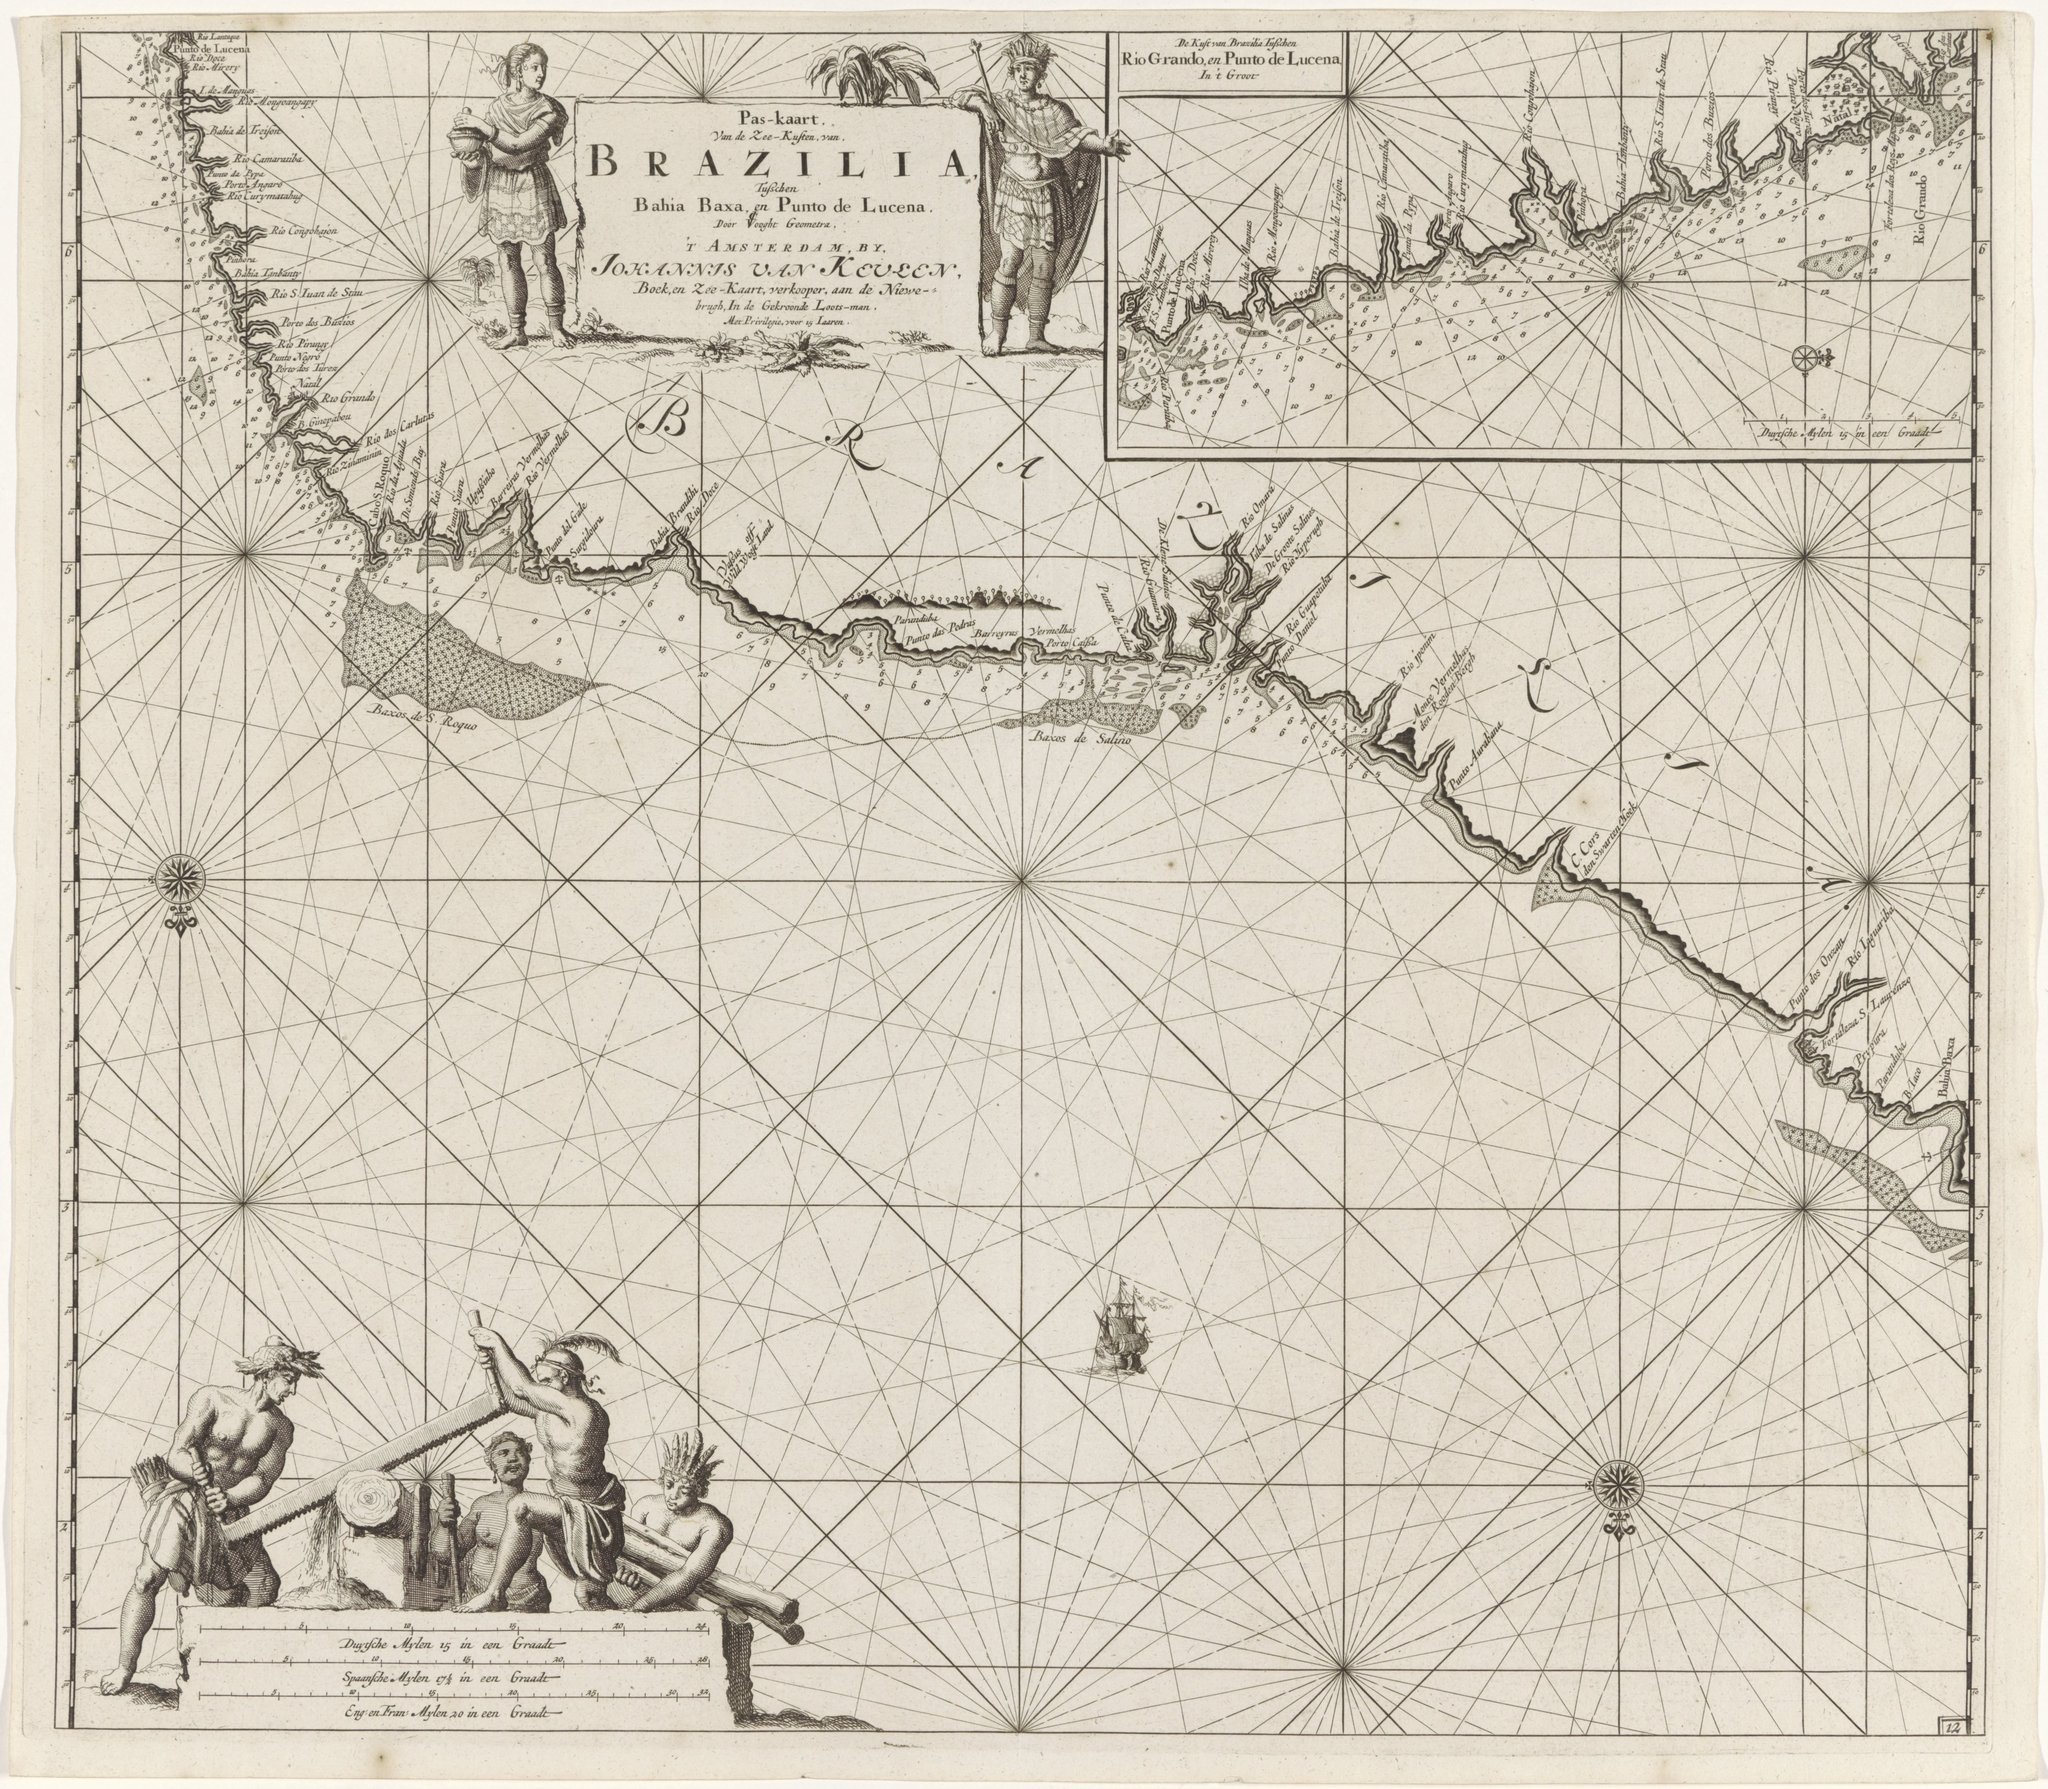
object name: print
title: Paskaart van een gedeelte van de noordoostkust van Brazilië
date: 1683-1799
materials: paper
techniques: engraving, etching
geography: amsterdam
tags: sailing-ship, sailing-boat, woodcutting, woodcutter ~ forestry, indigenous peoples of south america, trees: palm-tree, americans with african roots, african-americans, brasil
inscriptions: collector's mark: Lugt 2228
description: Paskaart van een gedeelte van de noordoostkust van Brazilië en een inzetkaart van de omgeving van de stad Natal, met drie kompasrozen. Middenboven de titel en het adres van de uitgever, geflankeerd door een man met een verentooi en een staf en een vrouw. Linksonder zijn vier mannen bezig met het zagen van hout. Onder de mannen staat de schaalverdeling, welke is weergegeven in Duitse, Spaanse en Engelse of Franse mijlen (schaal: c. 1:1.100.000).